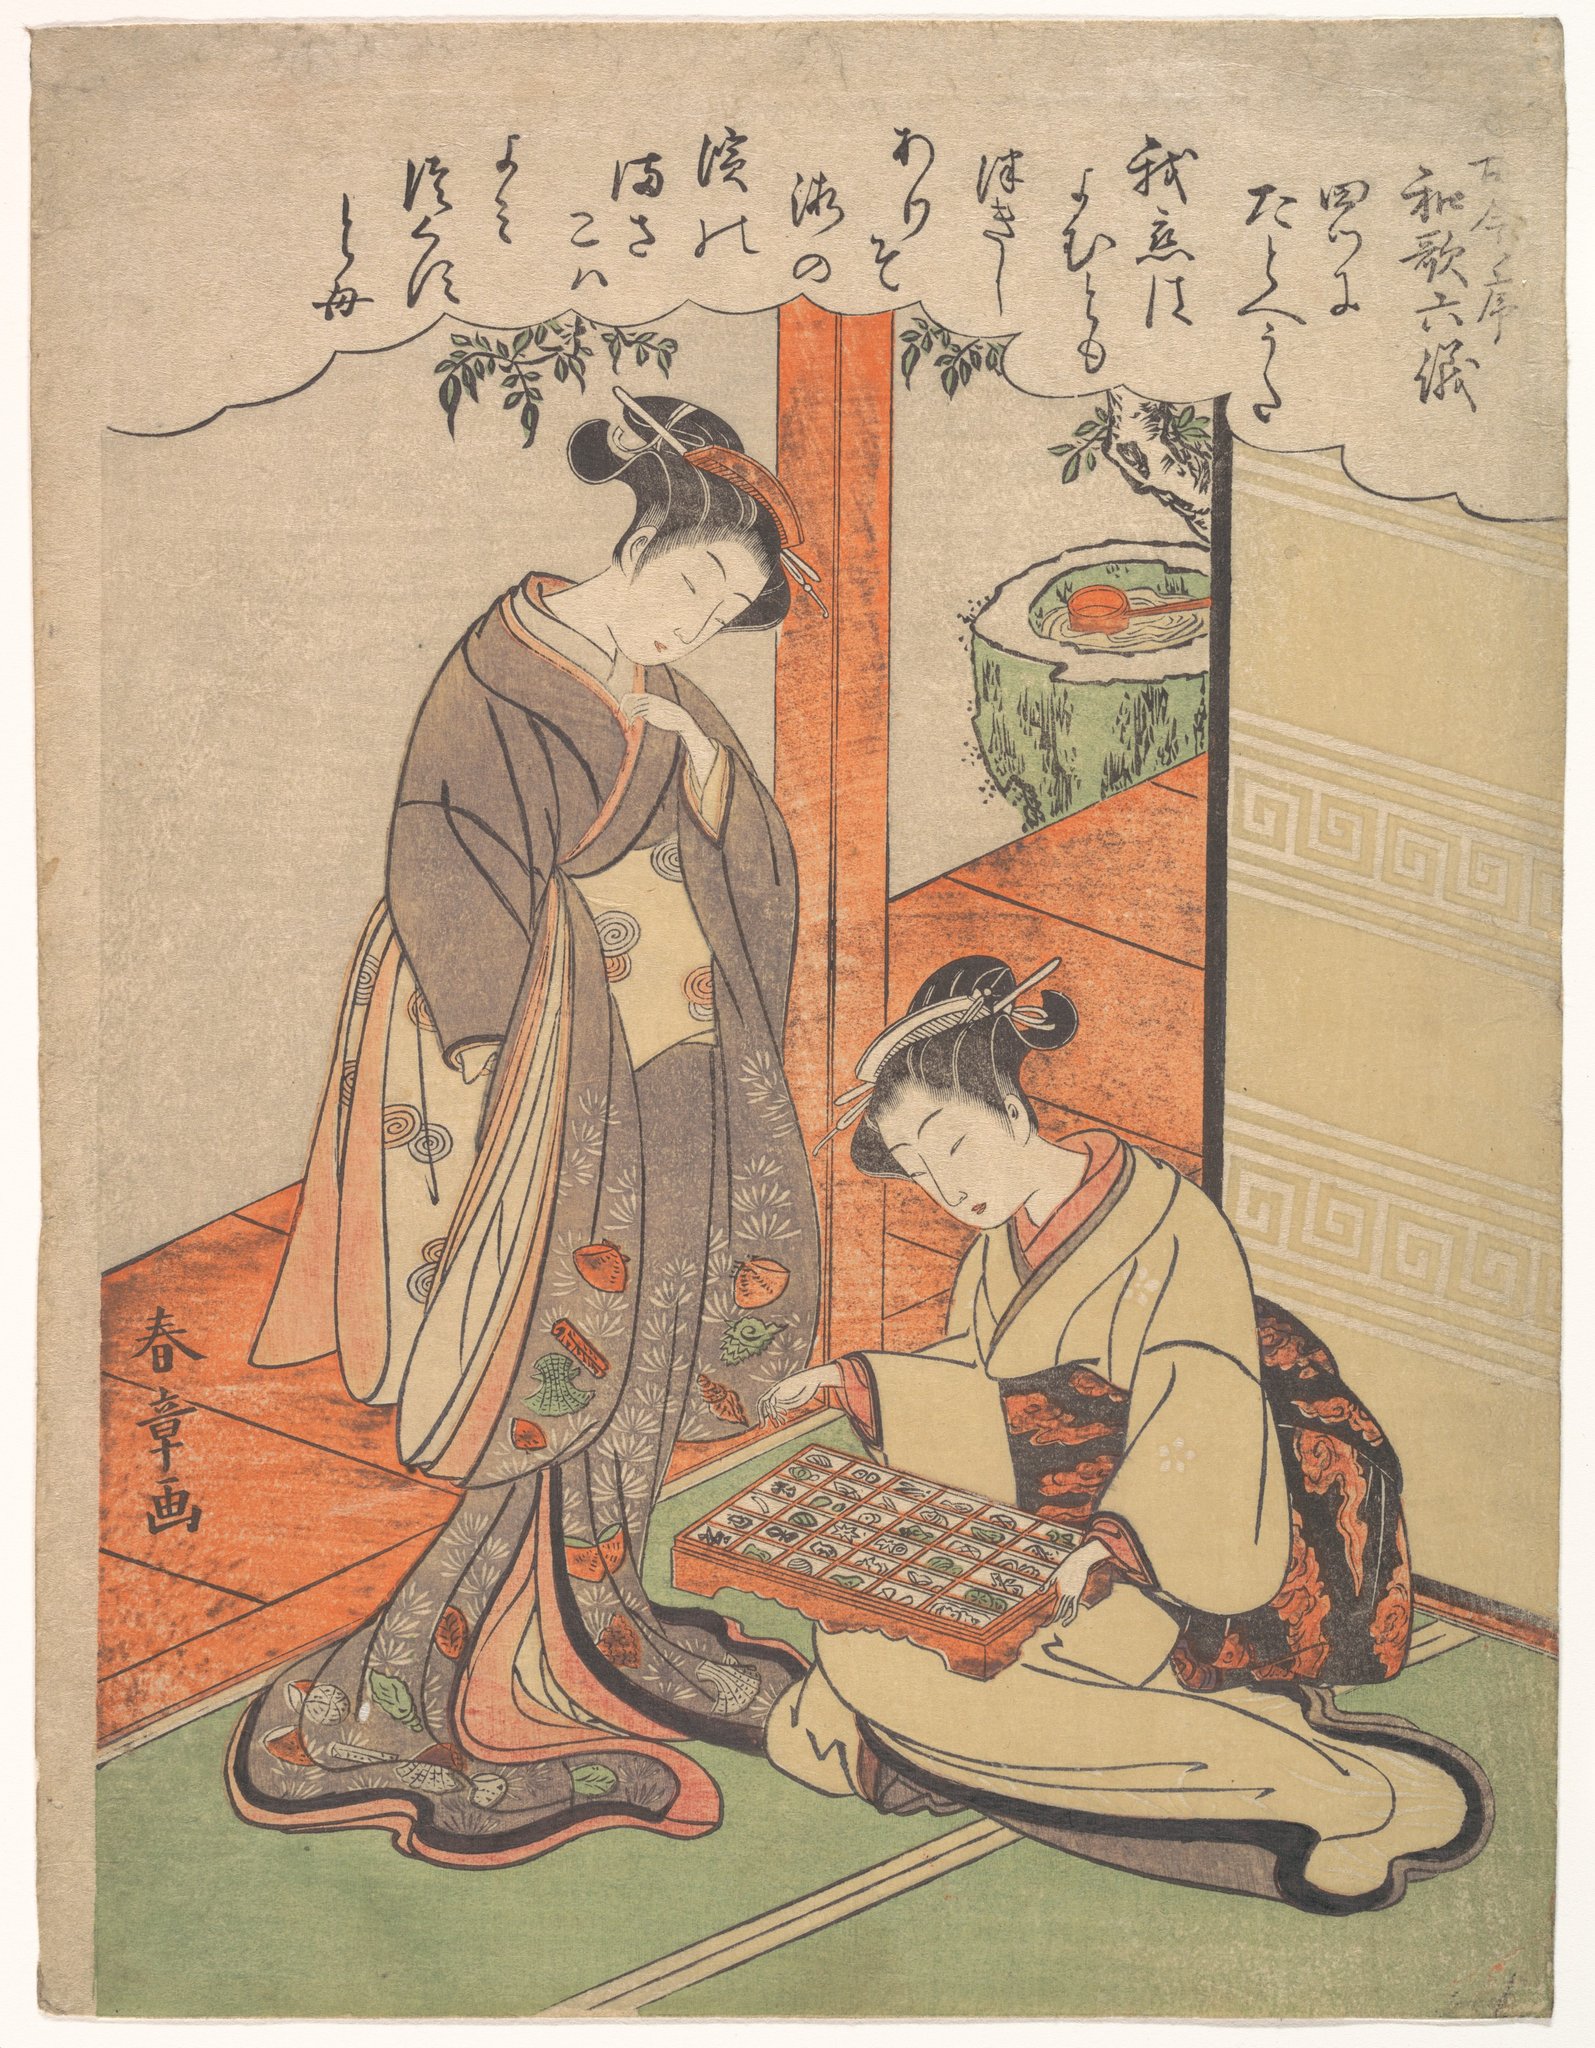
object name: woodblock print nishiki e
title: Analogy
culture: japanese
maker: katsukawa shunshō 勝川春章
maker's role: artist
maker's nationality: japanese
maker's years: 1726-1792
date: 1767-1800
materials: ink, paper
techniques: nishiki e, woodblock print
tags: women,shells,trays